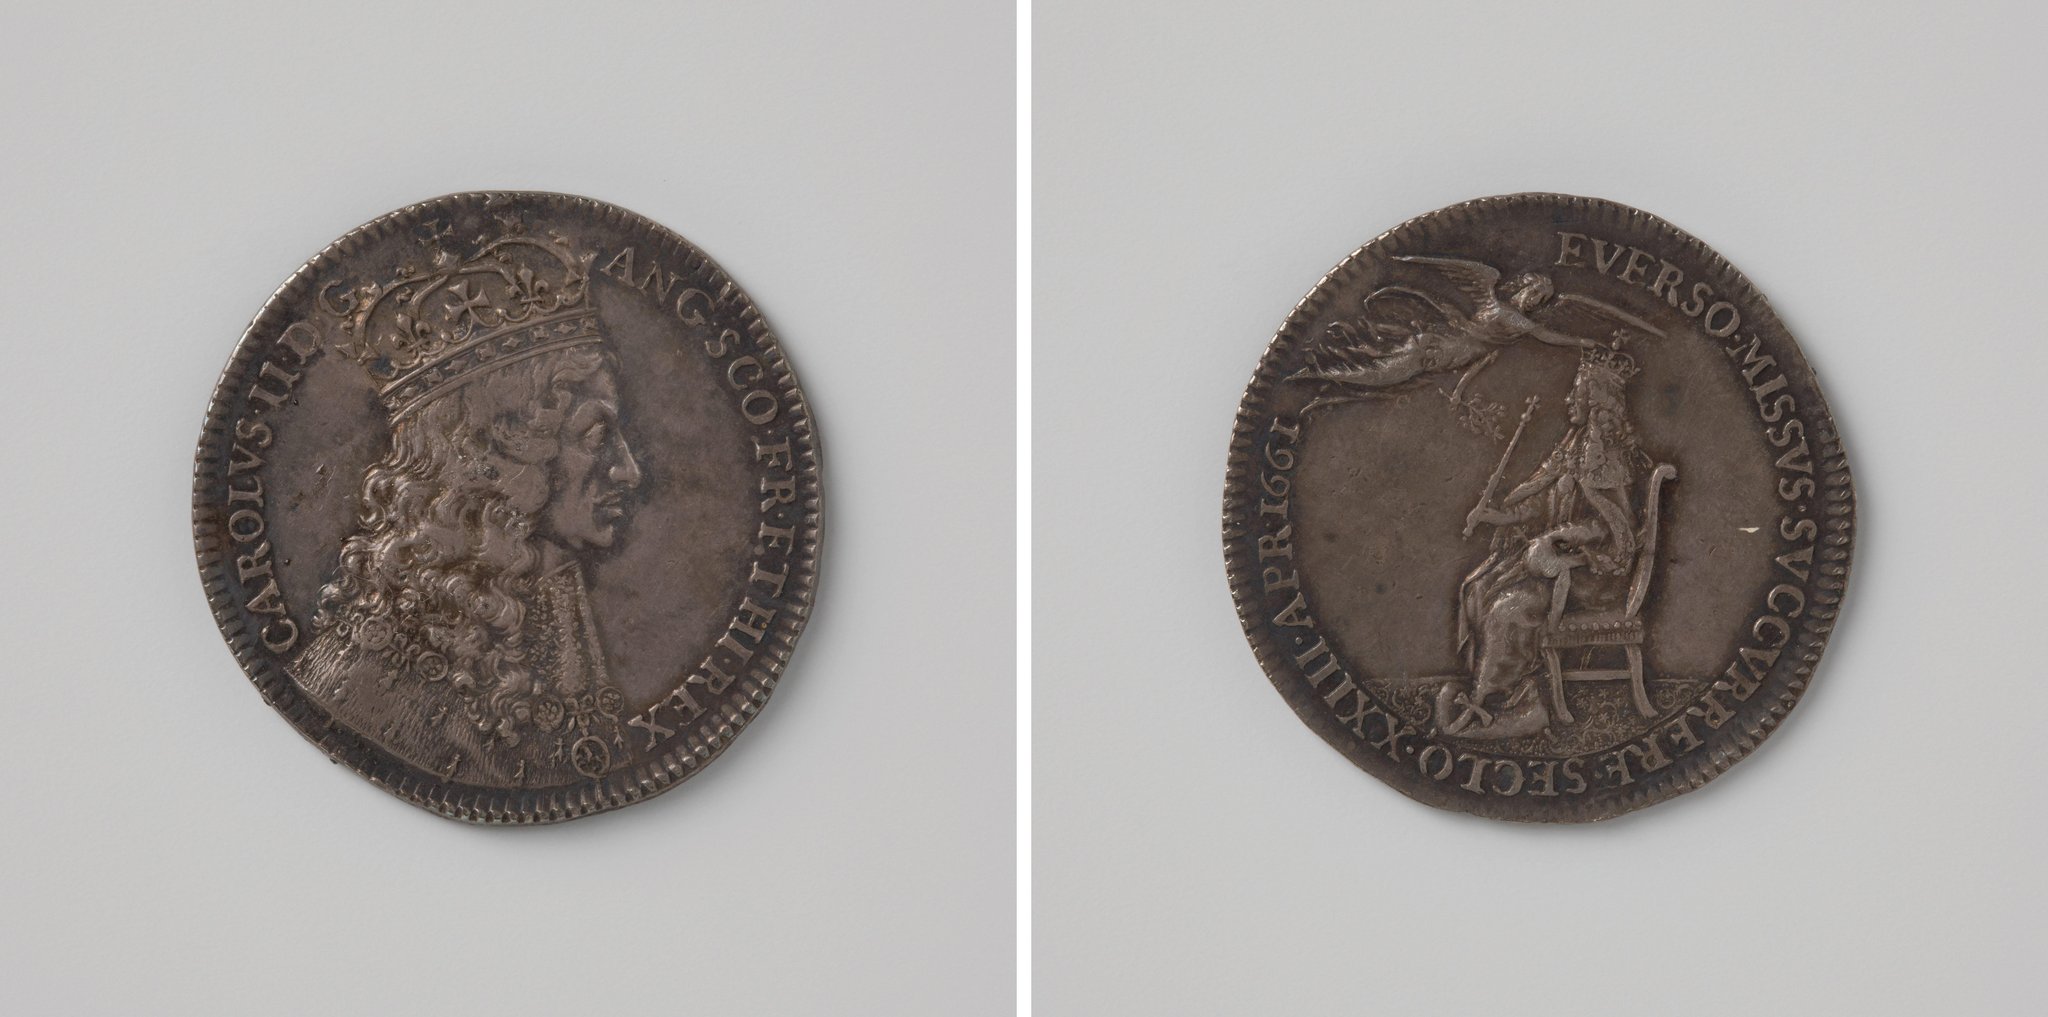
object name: strooipenning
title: Kroning van Karel II van Engeland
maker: thomas simon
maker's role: medailleur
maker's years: 1618-1665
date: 1661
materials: silver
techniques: striking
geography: london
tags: london, karel ii (koning van engeland)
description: Zilveren penning. Voorzijde: borststuk man met kroon binnen omschrift. Keerzijde: zittende koning wordt door engel gekroond binnen omschrift